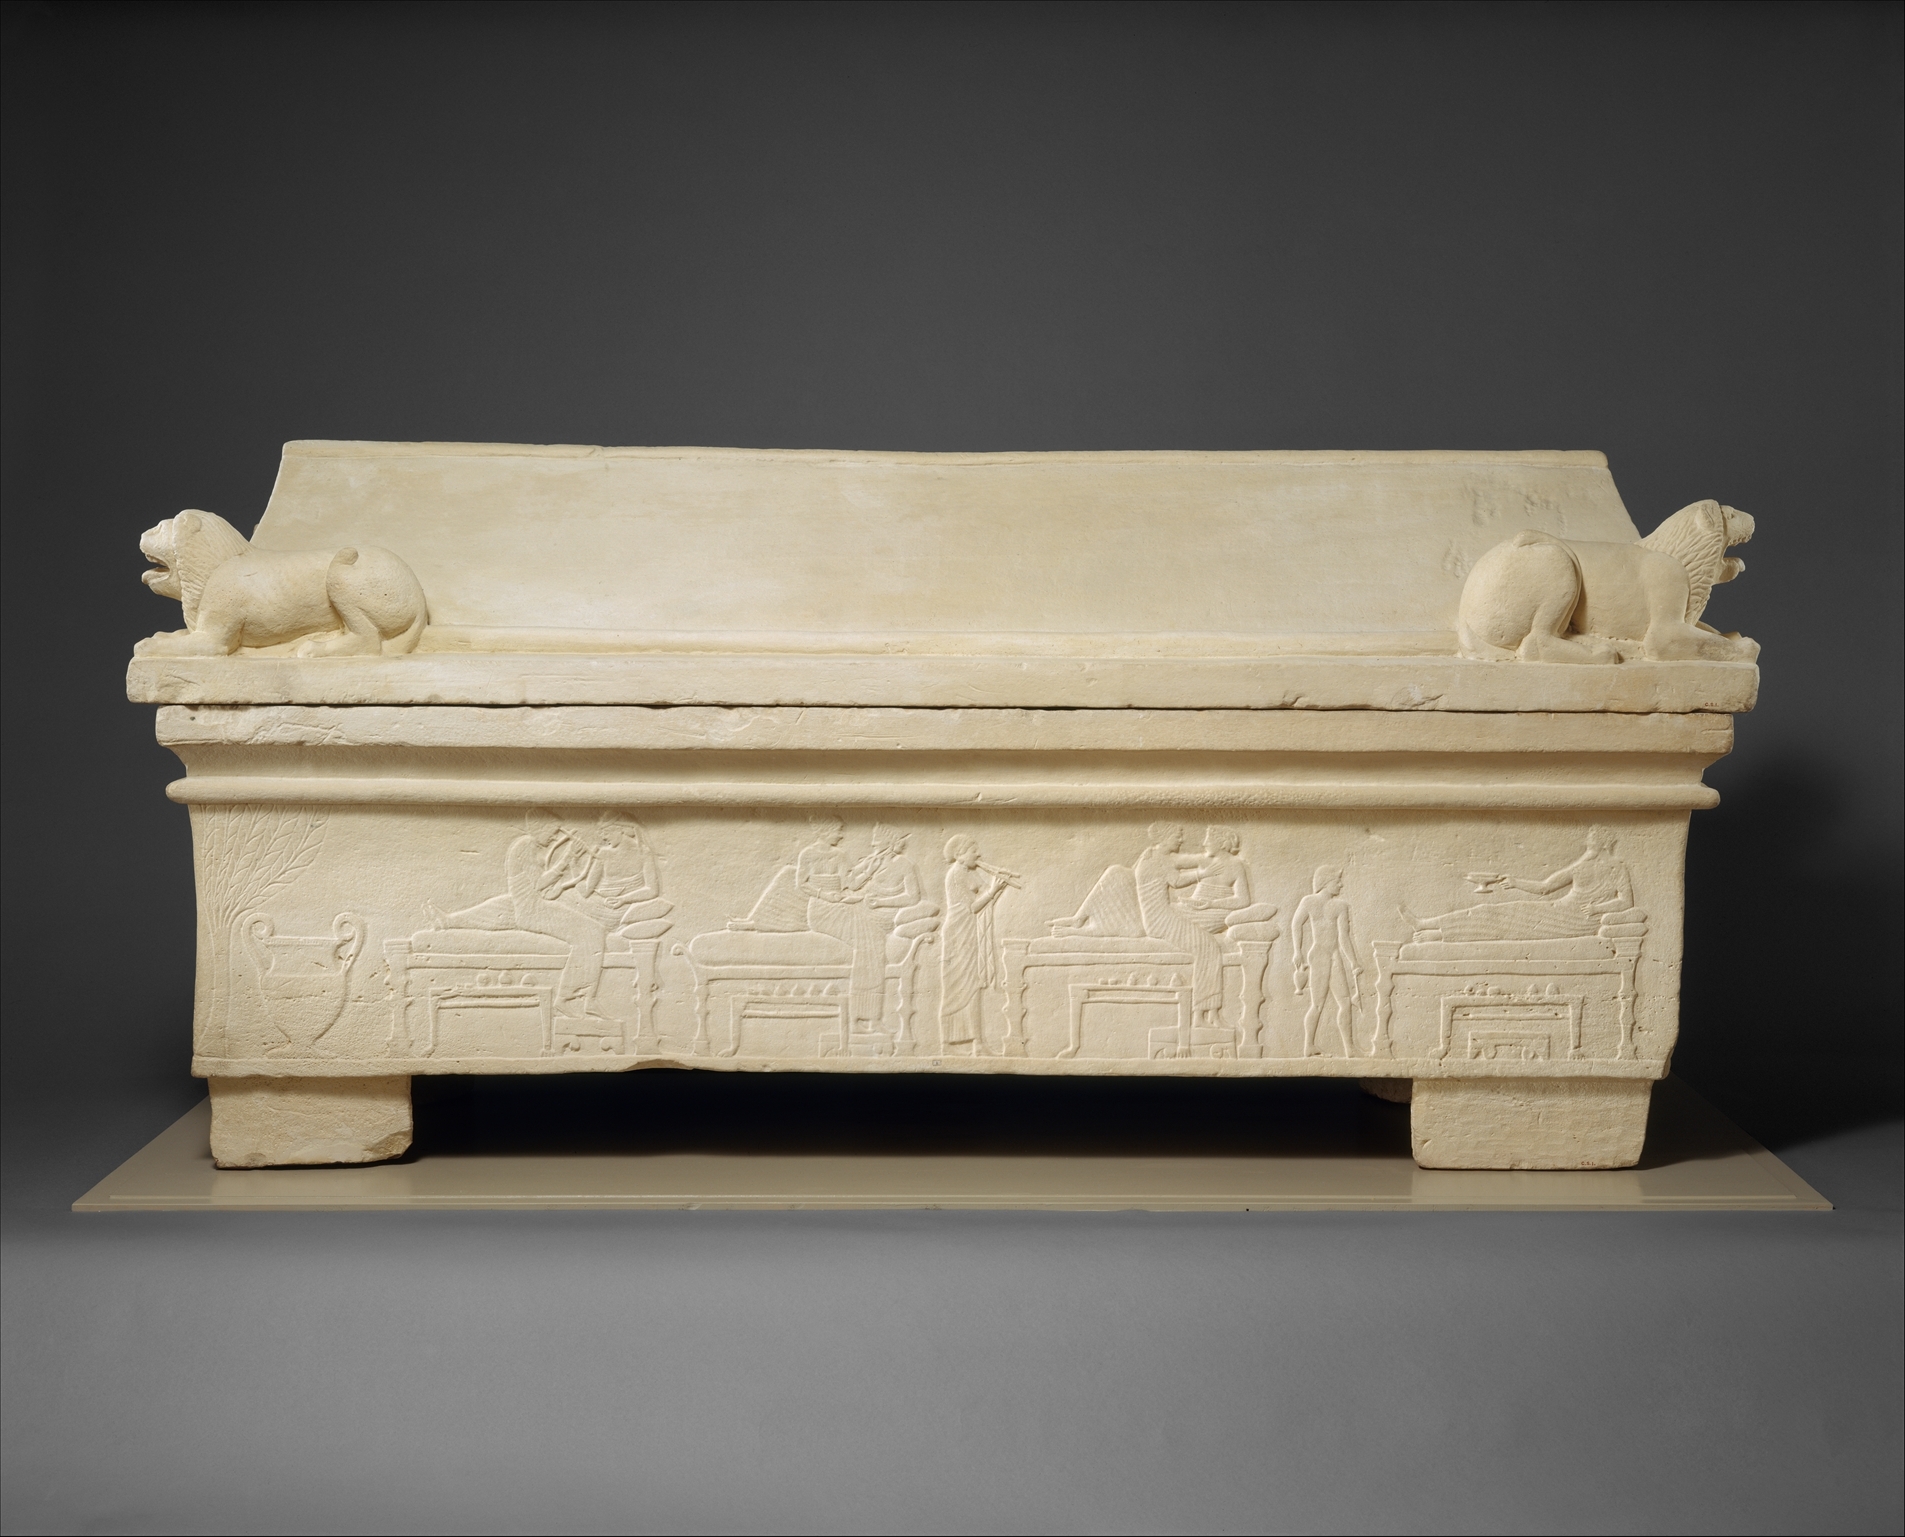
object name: sarcophagus, golgoi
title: Limestone sarcophagus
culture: cypriot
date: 475-450 BCE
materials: limestone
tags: musical instruments,hunting,medusa,perseus,lions,chariots